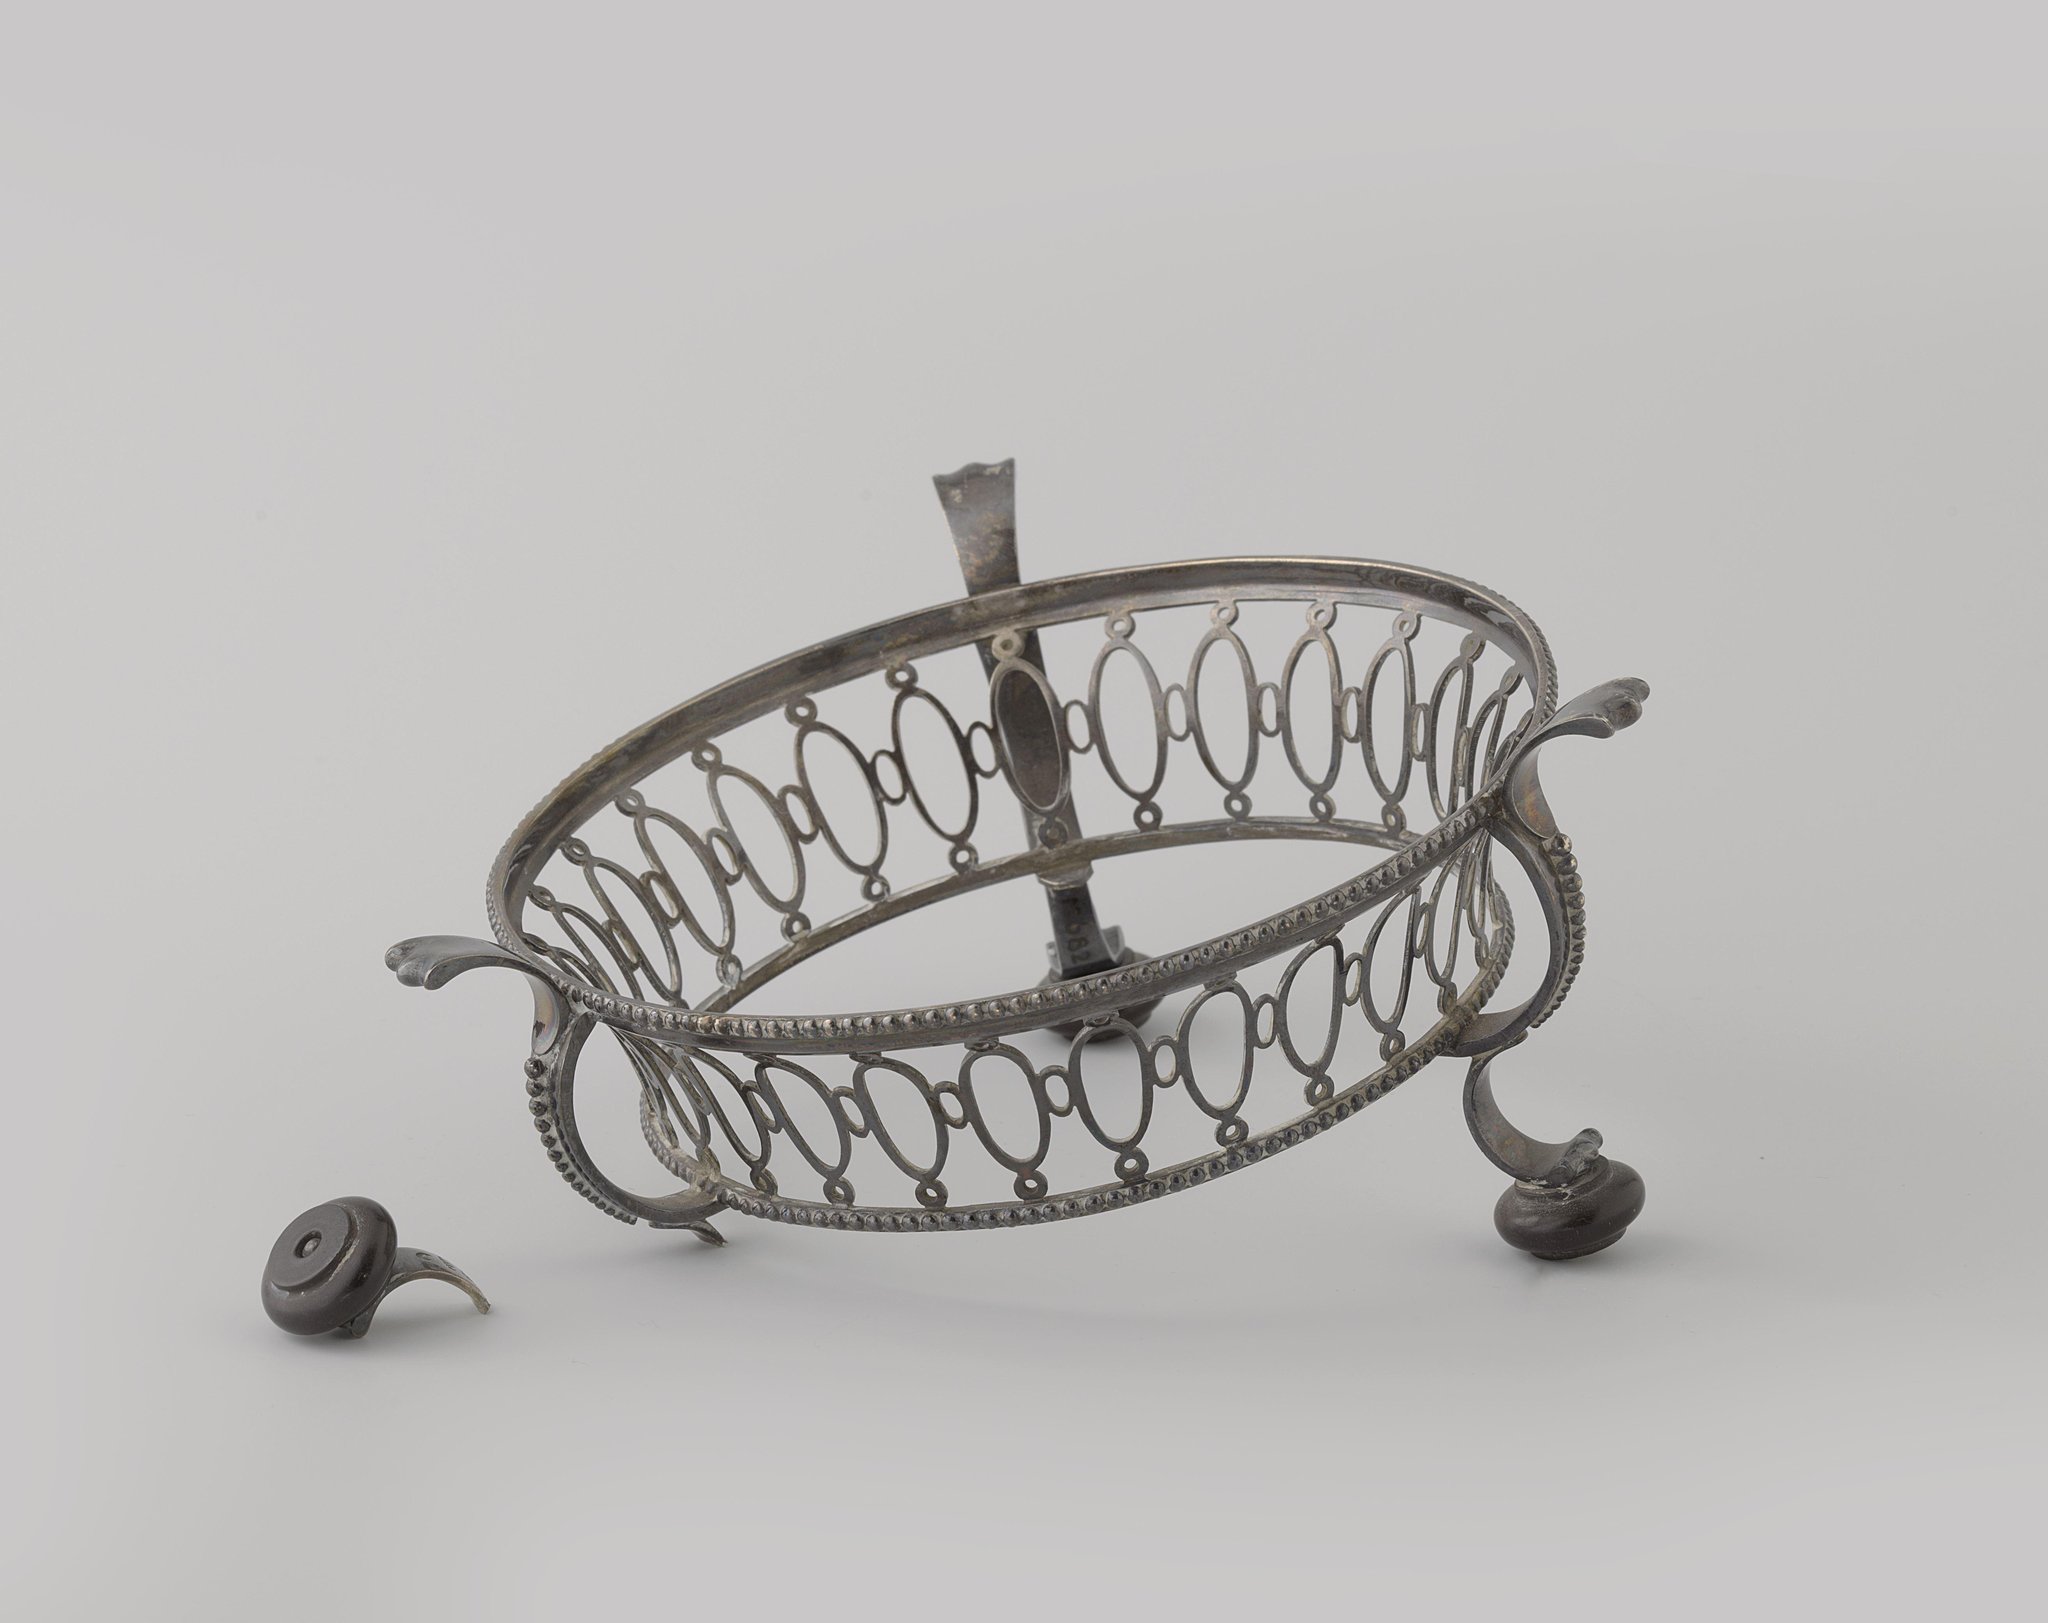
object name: komfoor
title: Komfoor, rond, met opengewerkte wand met ovalen en afgezet met parellijsten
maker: jan buijsen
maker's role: silversmith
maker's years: 1749-1813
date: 1786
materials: brass, wood, silver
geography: amsterdam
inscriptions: duty mark, town mark, maker's mark, : ‘N’, date letter: ‘B’, alloy mark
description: De ronde komforen (A en B) zijn voorzien van een geelkoperen binnenbak (ontbreekt bij A) en rusten met drie gegoten poten op ebbenhouten, geprofileerde klossen. De poten zijn opgebouwd uit drie C-voluten waarvan de middelste, die zich iets verbreedt, licht ingesnoerd is en versierd met een rand van in grootte toenemende parels, en waarvan de onderste en bovenste zich verbreden naar een verdikt, voluutachtig uiteinde. De gewelfde wand van het komfoor rust met zijn rechte onderrand op de drie middelste voluten van de poten. De geprofileerde bovenrand is verbonden met de bovenzijde van deze voluten. Onder- en bovenrand zijn versierd met een parellijst. Daartussen is de wand opengewerkt met ovalen, die met boven- en onderrand door cirkeltjes verbonden zijn en met elkaar door kleinere ovalen. De middelste voluten van de poten vormen aan de onderzijde lipjes, waarop de komvormige binnenbak met een platte rand rust.